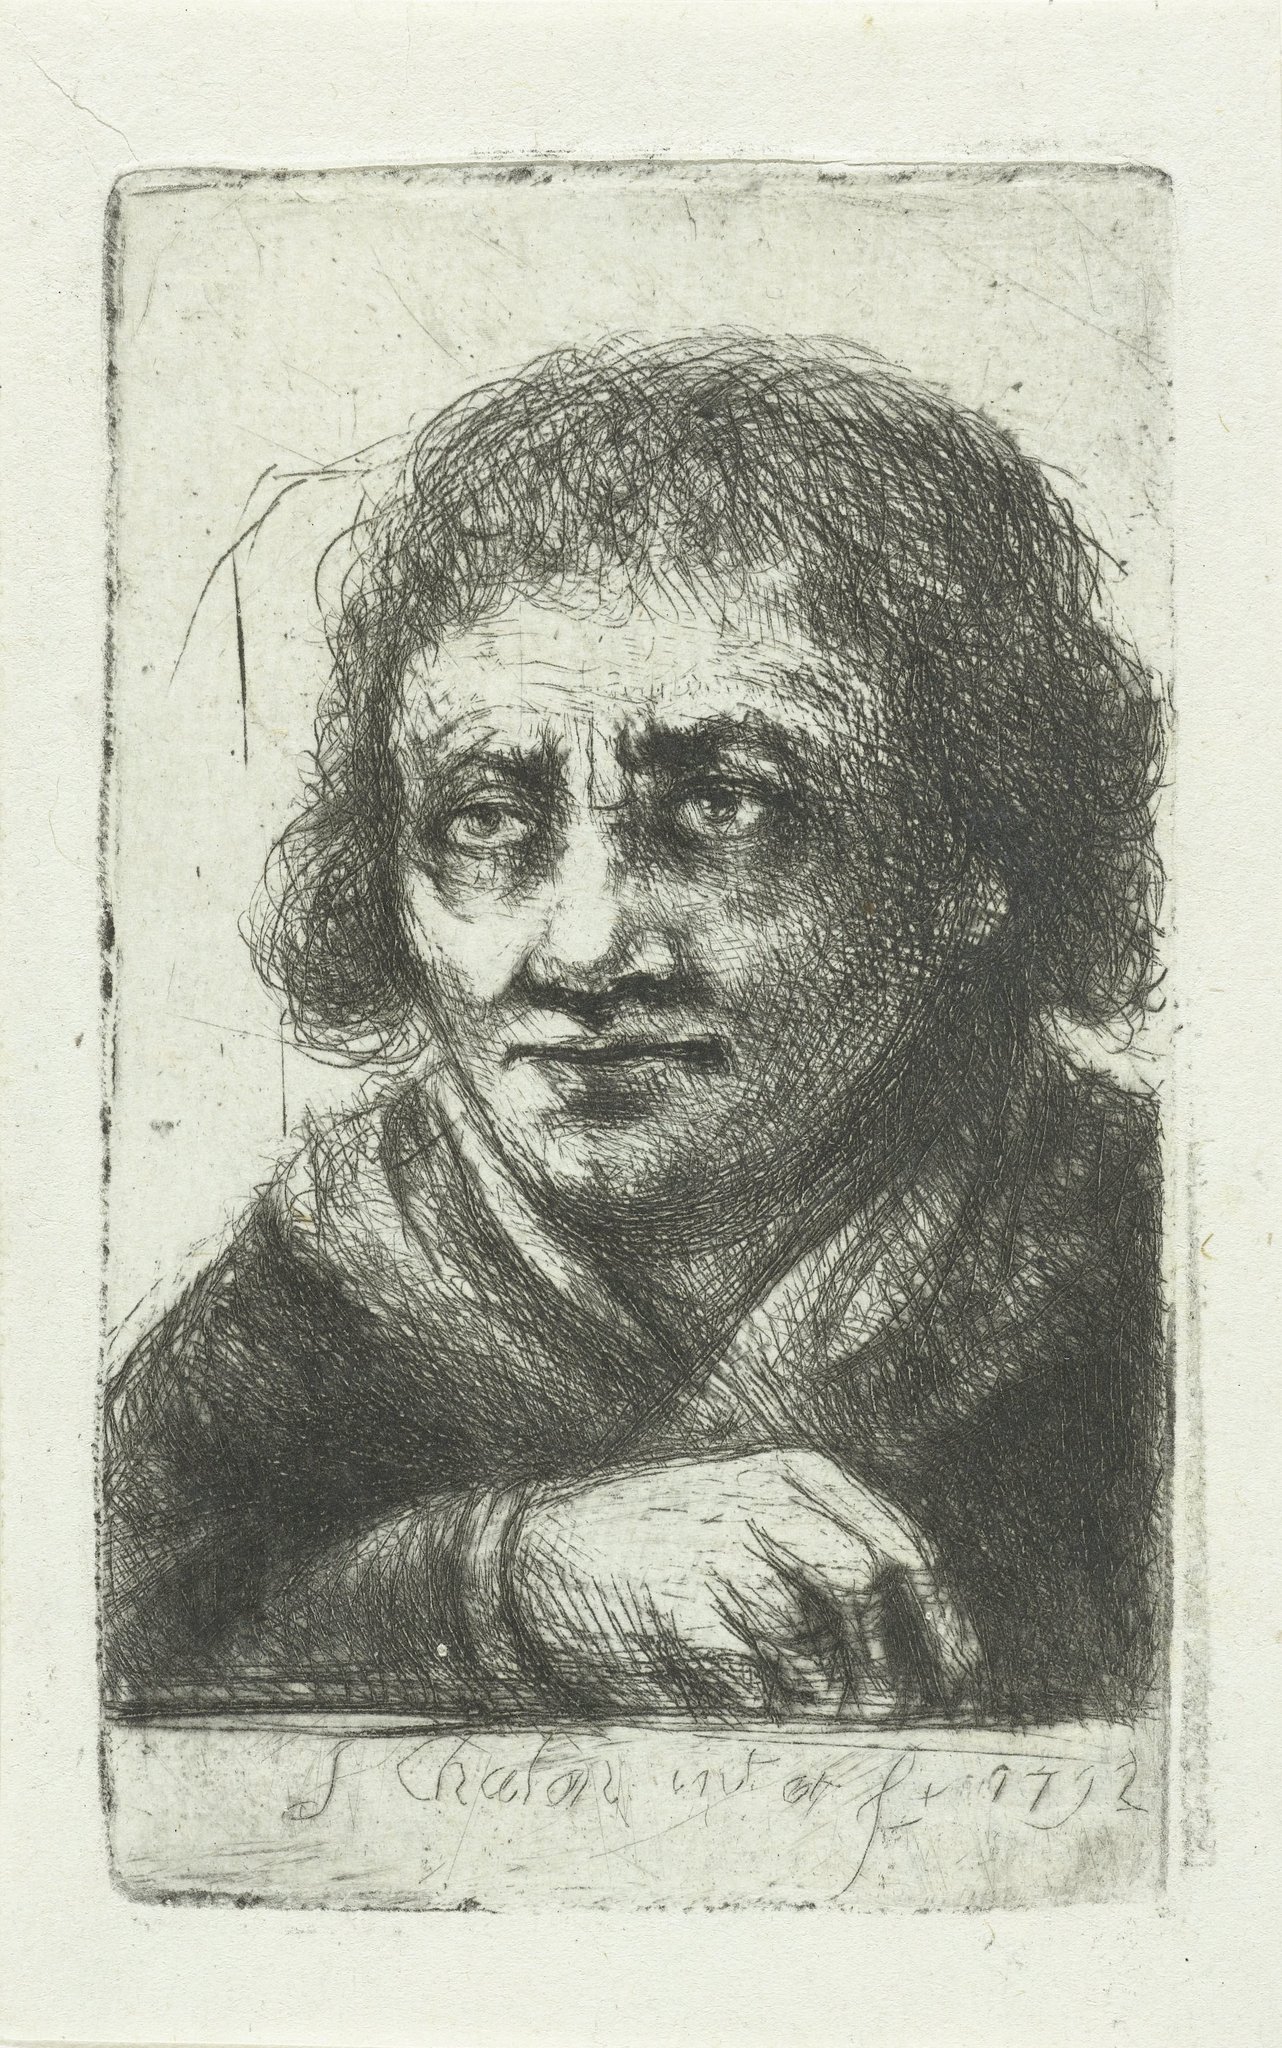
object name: print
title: Volwassen man, zijn rechterhand zichtbaar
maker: jan chalon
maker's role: print maker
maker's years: 1738-1795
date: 1792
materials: paper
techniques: drypoint, etching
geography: northern netherlands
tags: morphology of human expression (+ adult male (human being))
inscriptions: date